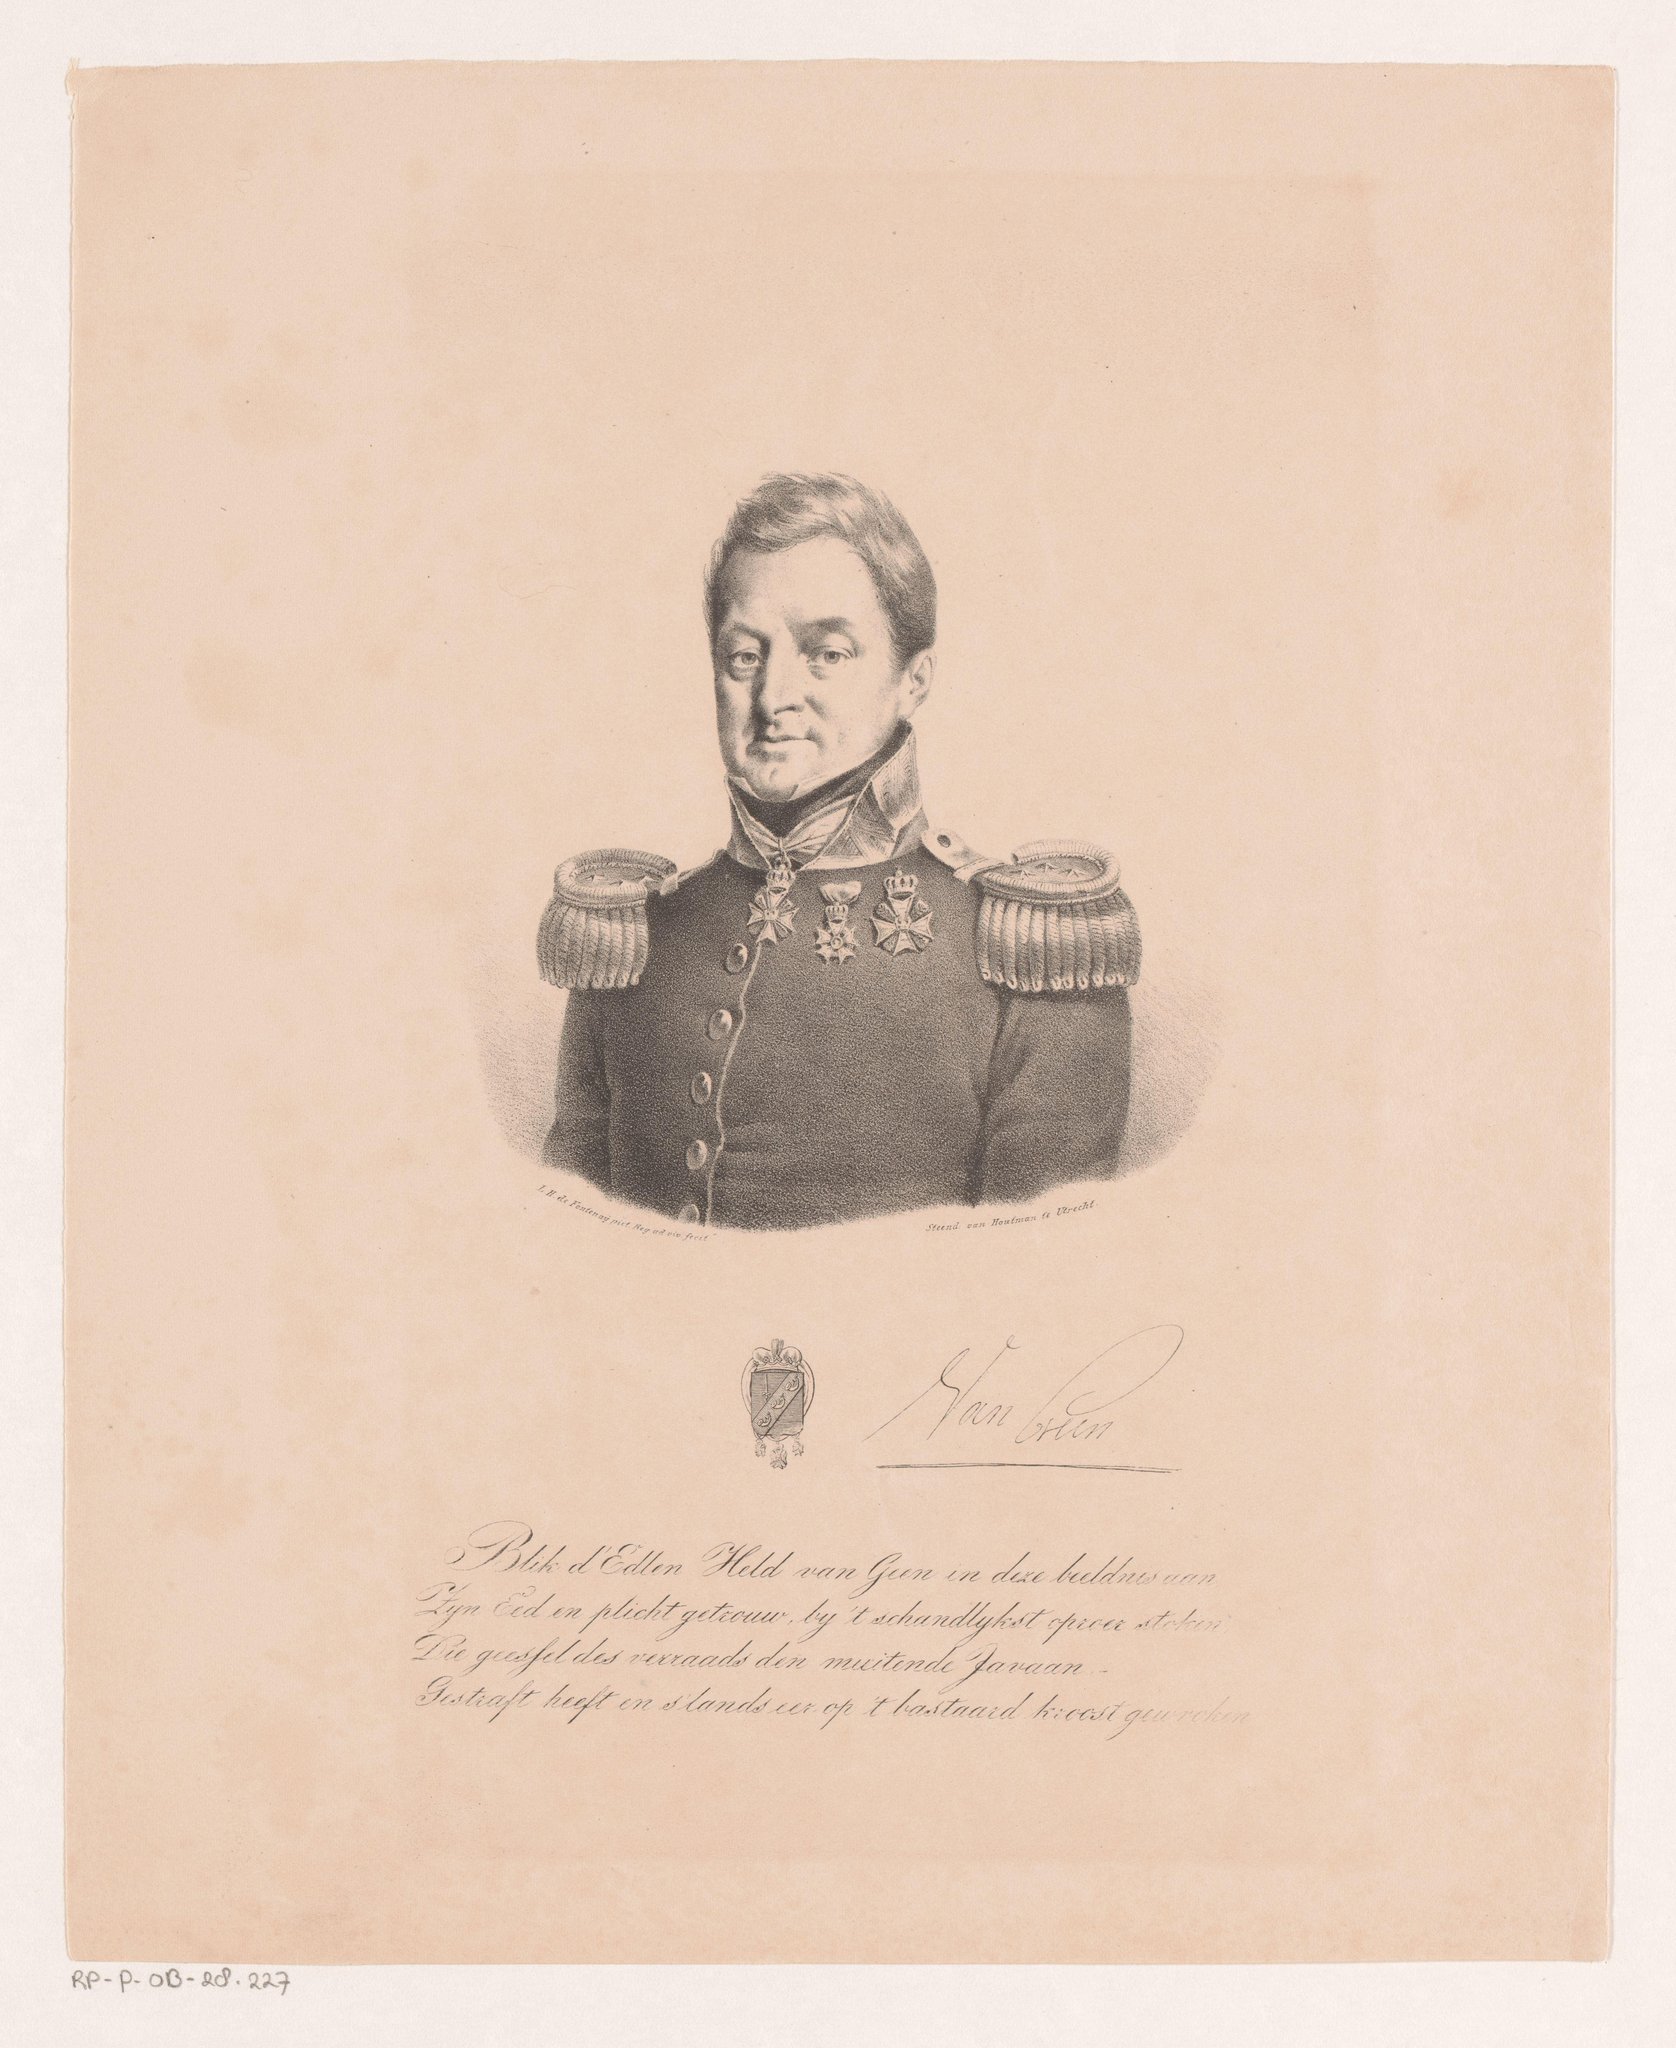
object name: print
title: Portret van Joseph Jacobus van Geen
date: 1810-1846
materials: paper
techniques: lithograph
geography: utrecht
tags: ghent, knighthood order, historical persons (+ (full) bust portrait)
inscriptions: collector's mark: Lugt 2228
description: De geportretteerde draagt een militair uniform met epauletten met drie sterren en drie ridderorden. Onder het portret zijn familiewapen, signatuur en een vierregelig onderschrift.